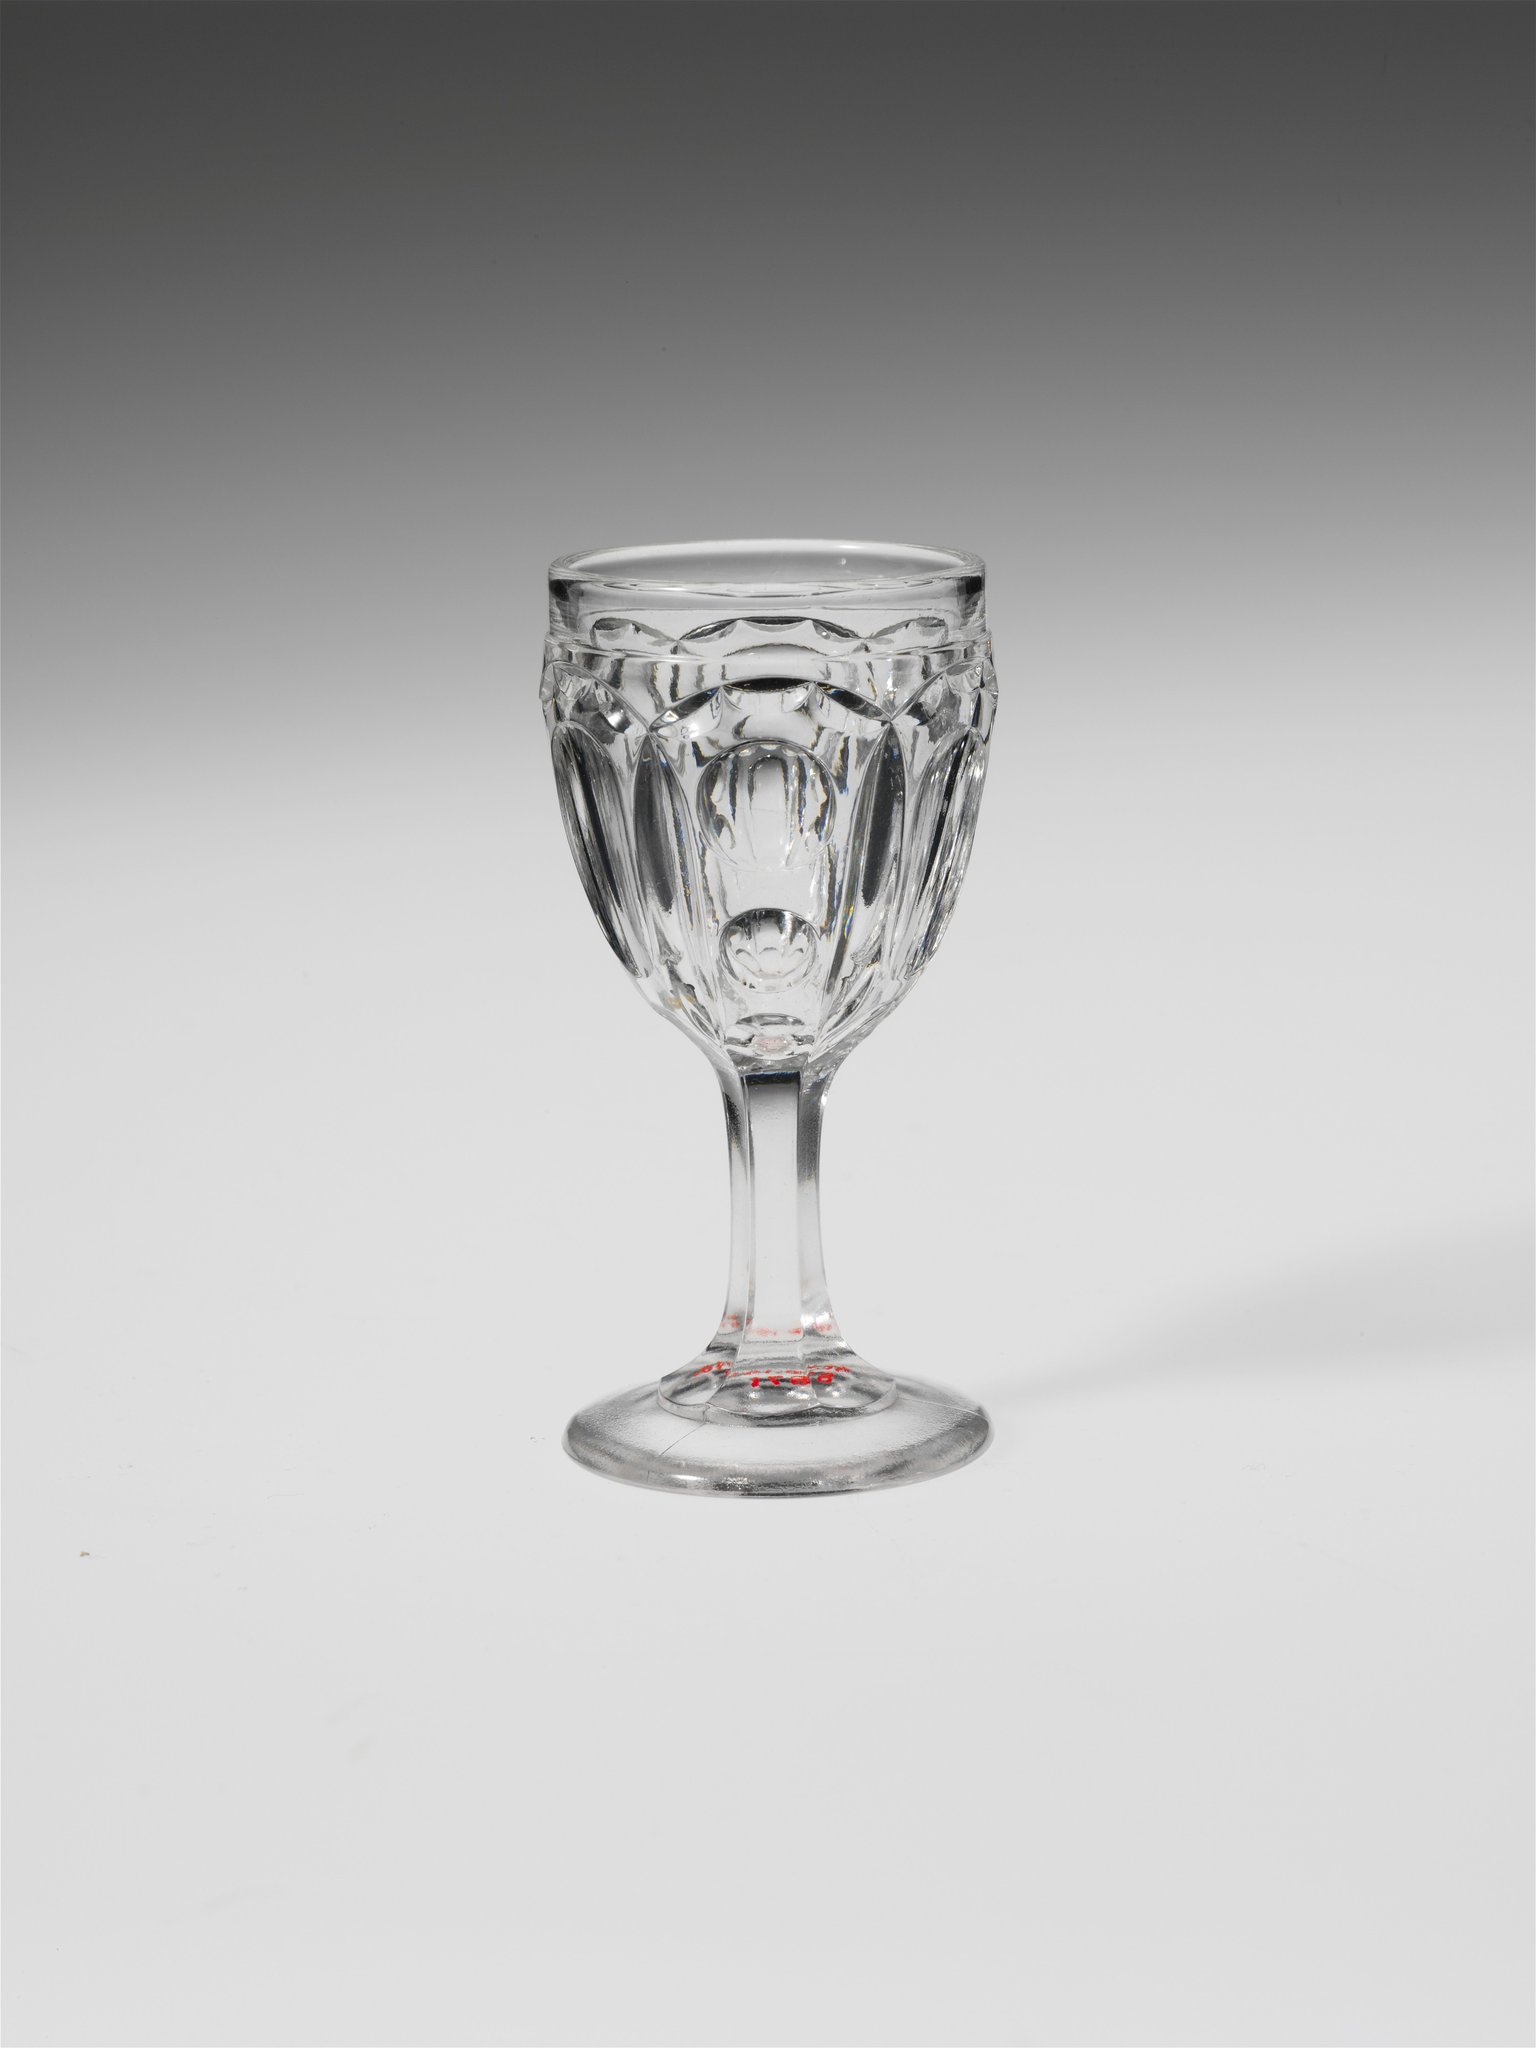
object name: cordial glass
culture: american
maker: new england glass company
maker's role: maker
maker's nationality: american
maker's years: 1818-1888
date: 1865-1870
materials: glass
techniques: pressed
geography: united states